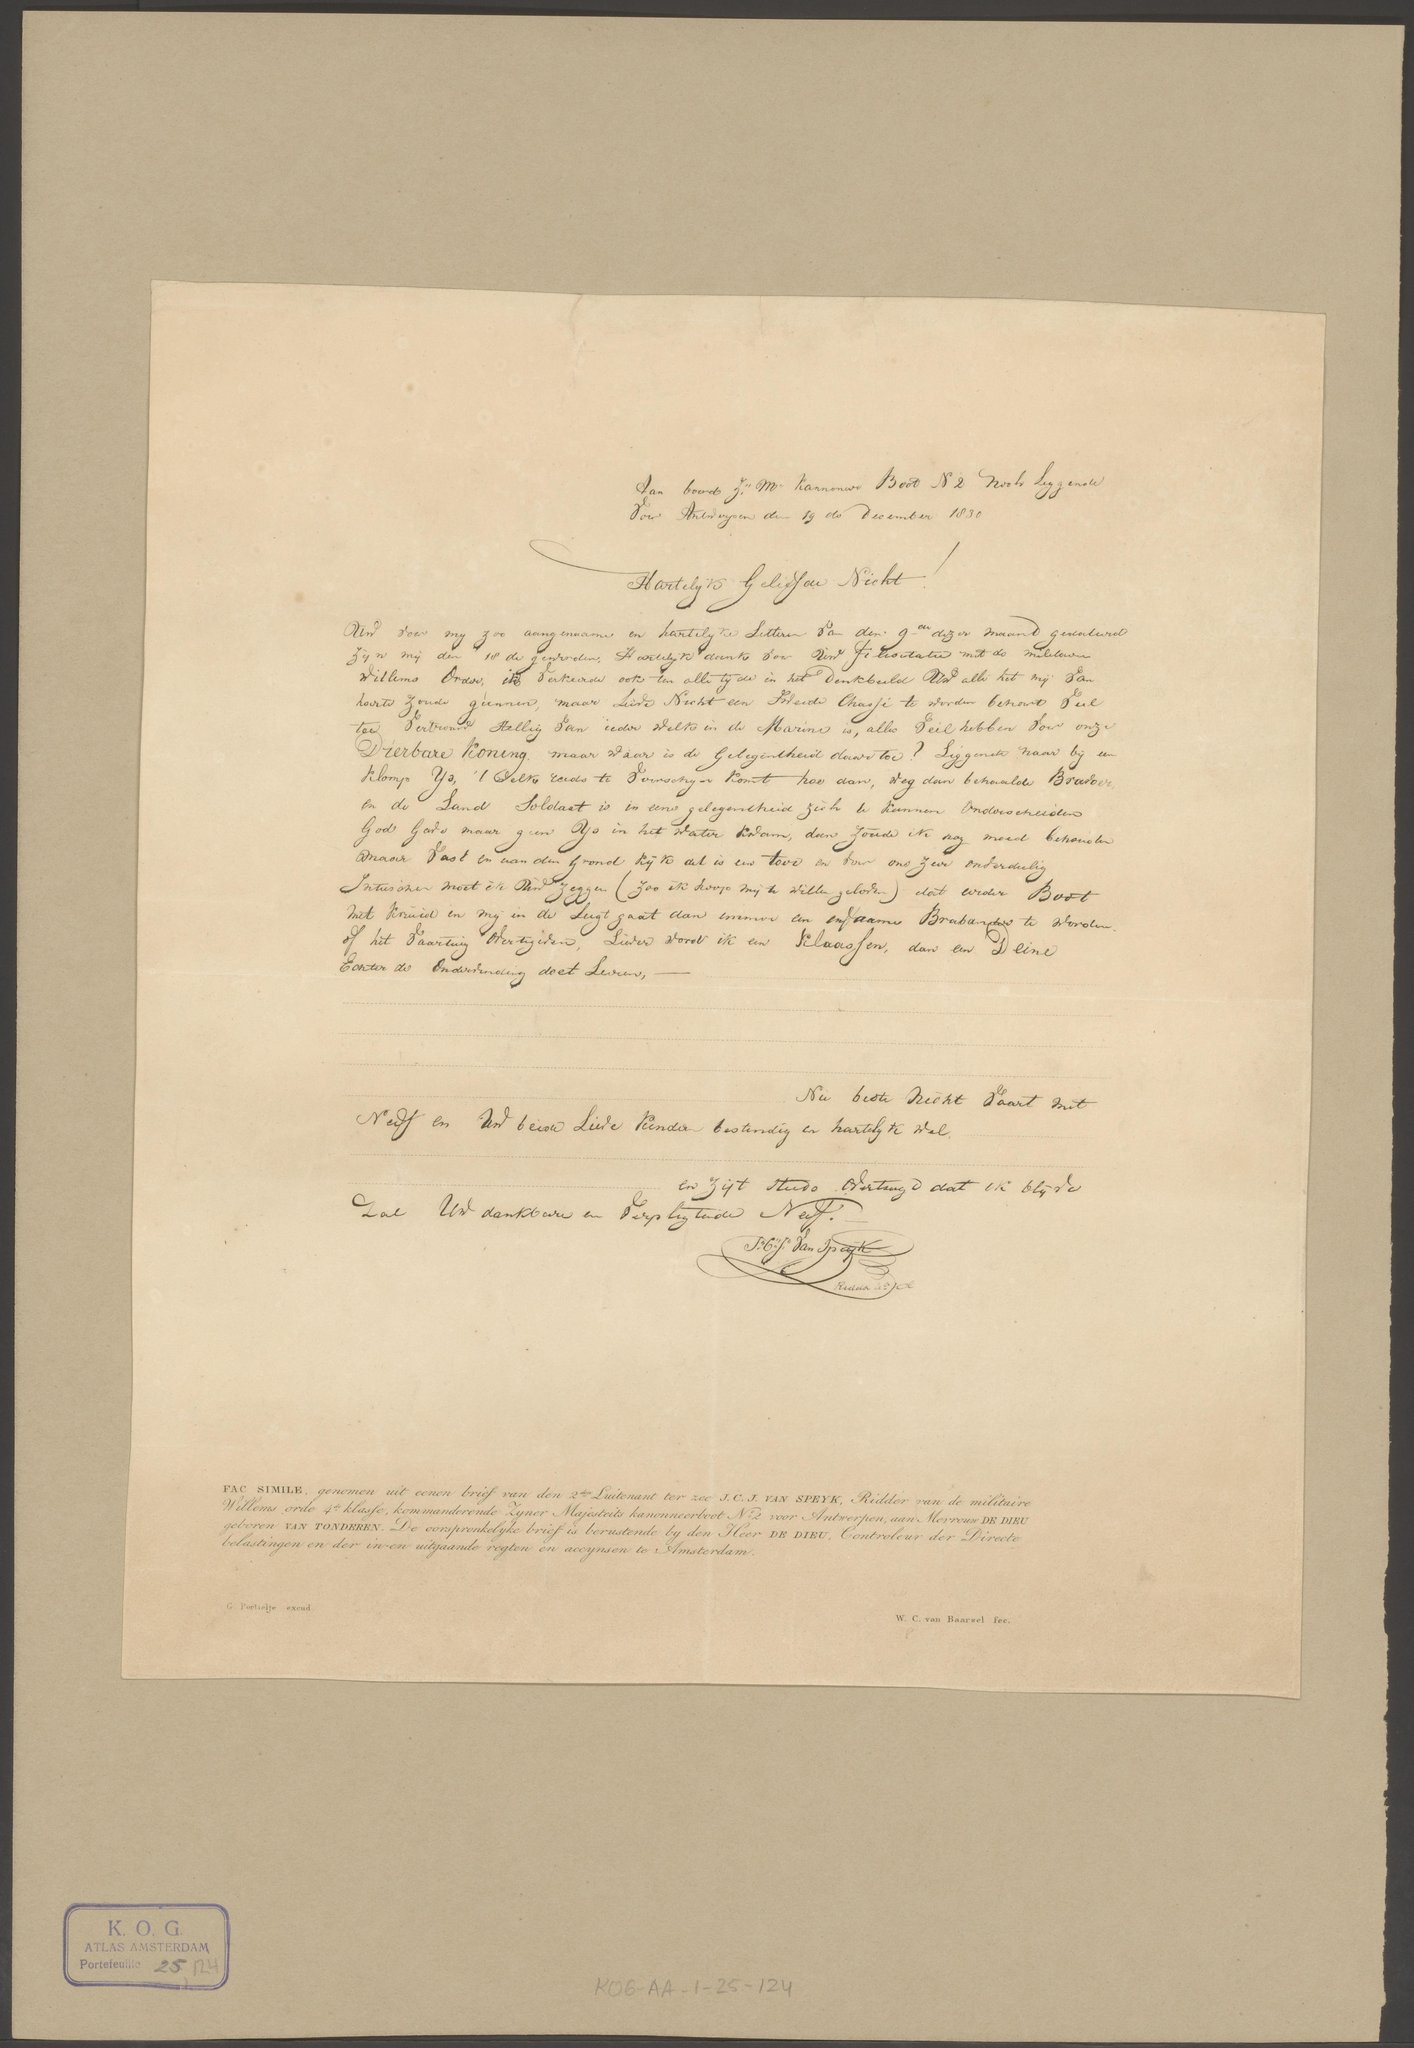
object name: facsimile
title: Facsimile van een brief van J.C.J. van Speyk aan zijn nicht mevrouw De Dieu van Tongeren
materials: paper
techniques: lithograph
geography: amsterdam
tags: amsterdam, antwerp, jan van speyk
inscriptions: collector's mark: ‘25.124’ Lugt 1641b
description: Onderwerpsrubriek binnen de Atlas Amsterdam: Krijgswezen I: De Admiraliteit van Amsterdam, D. J.C. van Speyk.